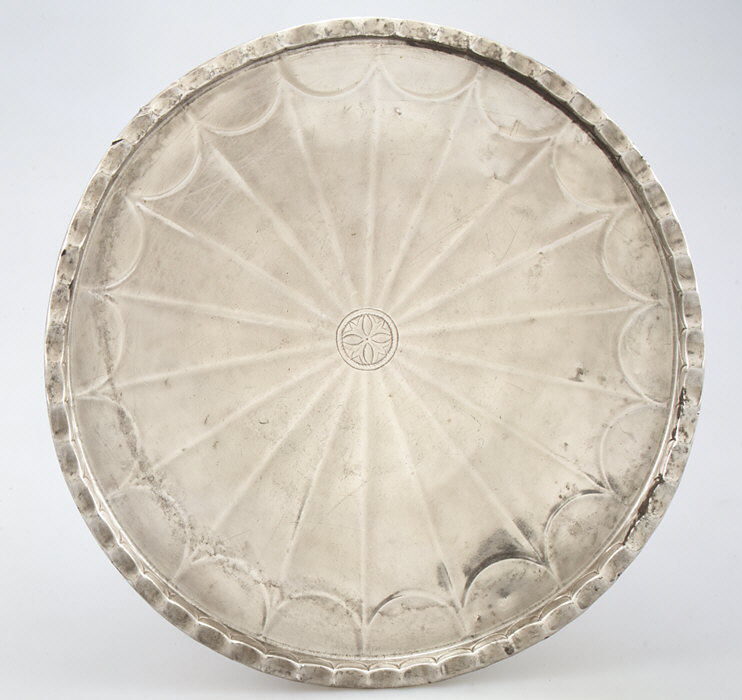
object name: plate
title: Ribbed Plate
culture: byzantine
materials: silver